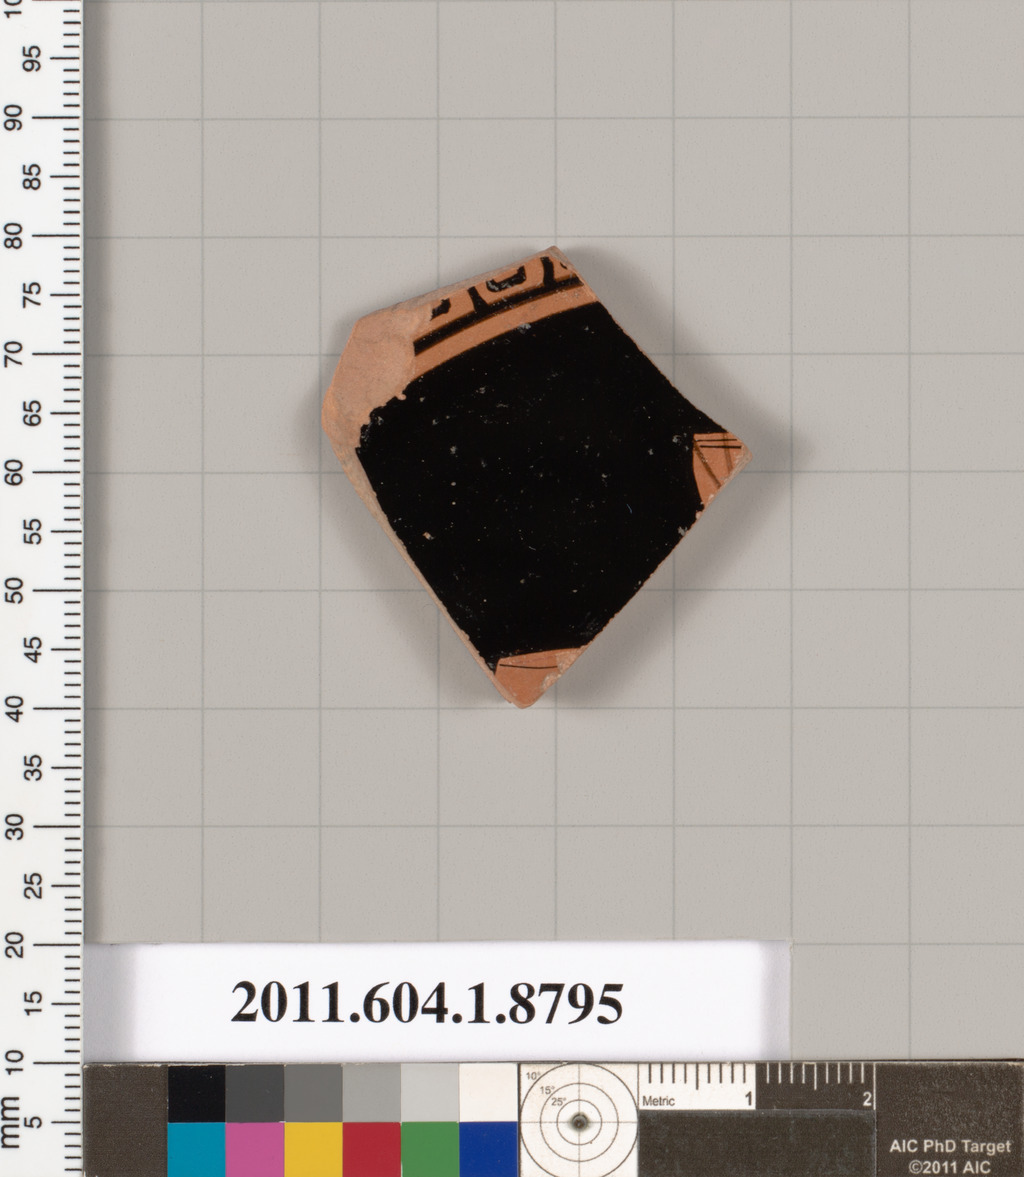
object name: kylix fragment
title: Terracotta fragment of a kylix (drinking cup)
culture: greek, attic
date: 490-480 BCE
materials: terracotta